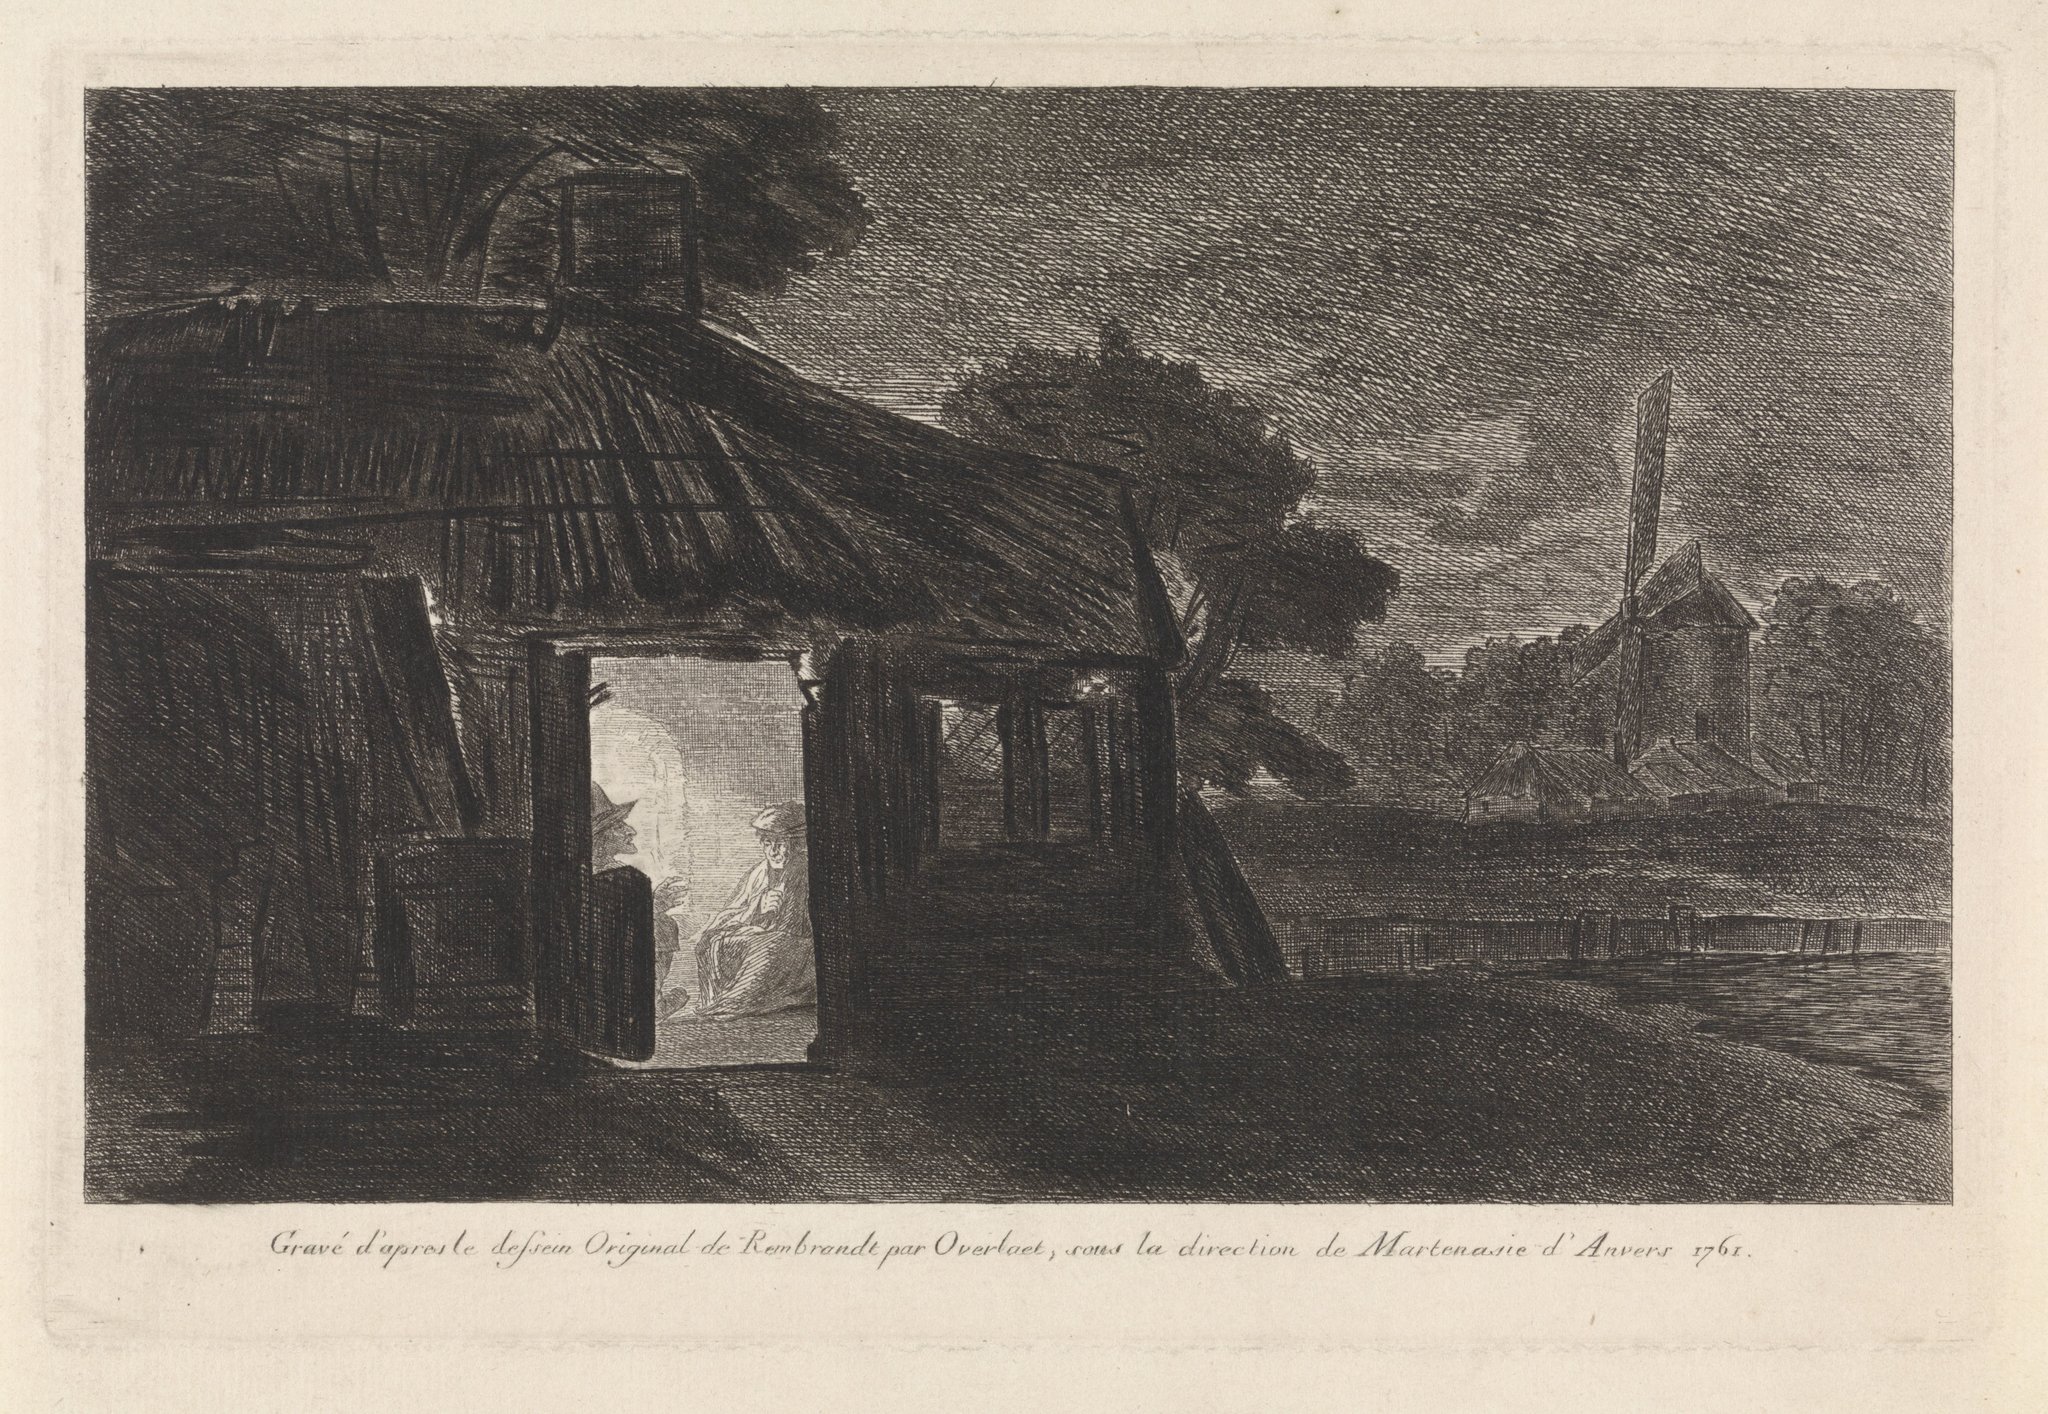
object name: print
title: Nachtstuk met twee figuren in een hut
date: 1761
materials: paper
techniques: etching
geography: antwerp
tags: warming oneself at a fire (or hearth, stove, fire-pan, brazier)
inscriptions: collector's mark: Lugt 2228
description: Landschap met links een hut met openstaande deur waardoor men een vrouw en een man bij het vuur ziet zitten.